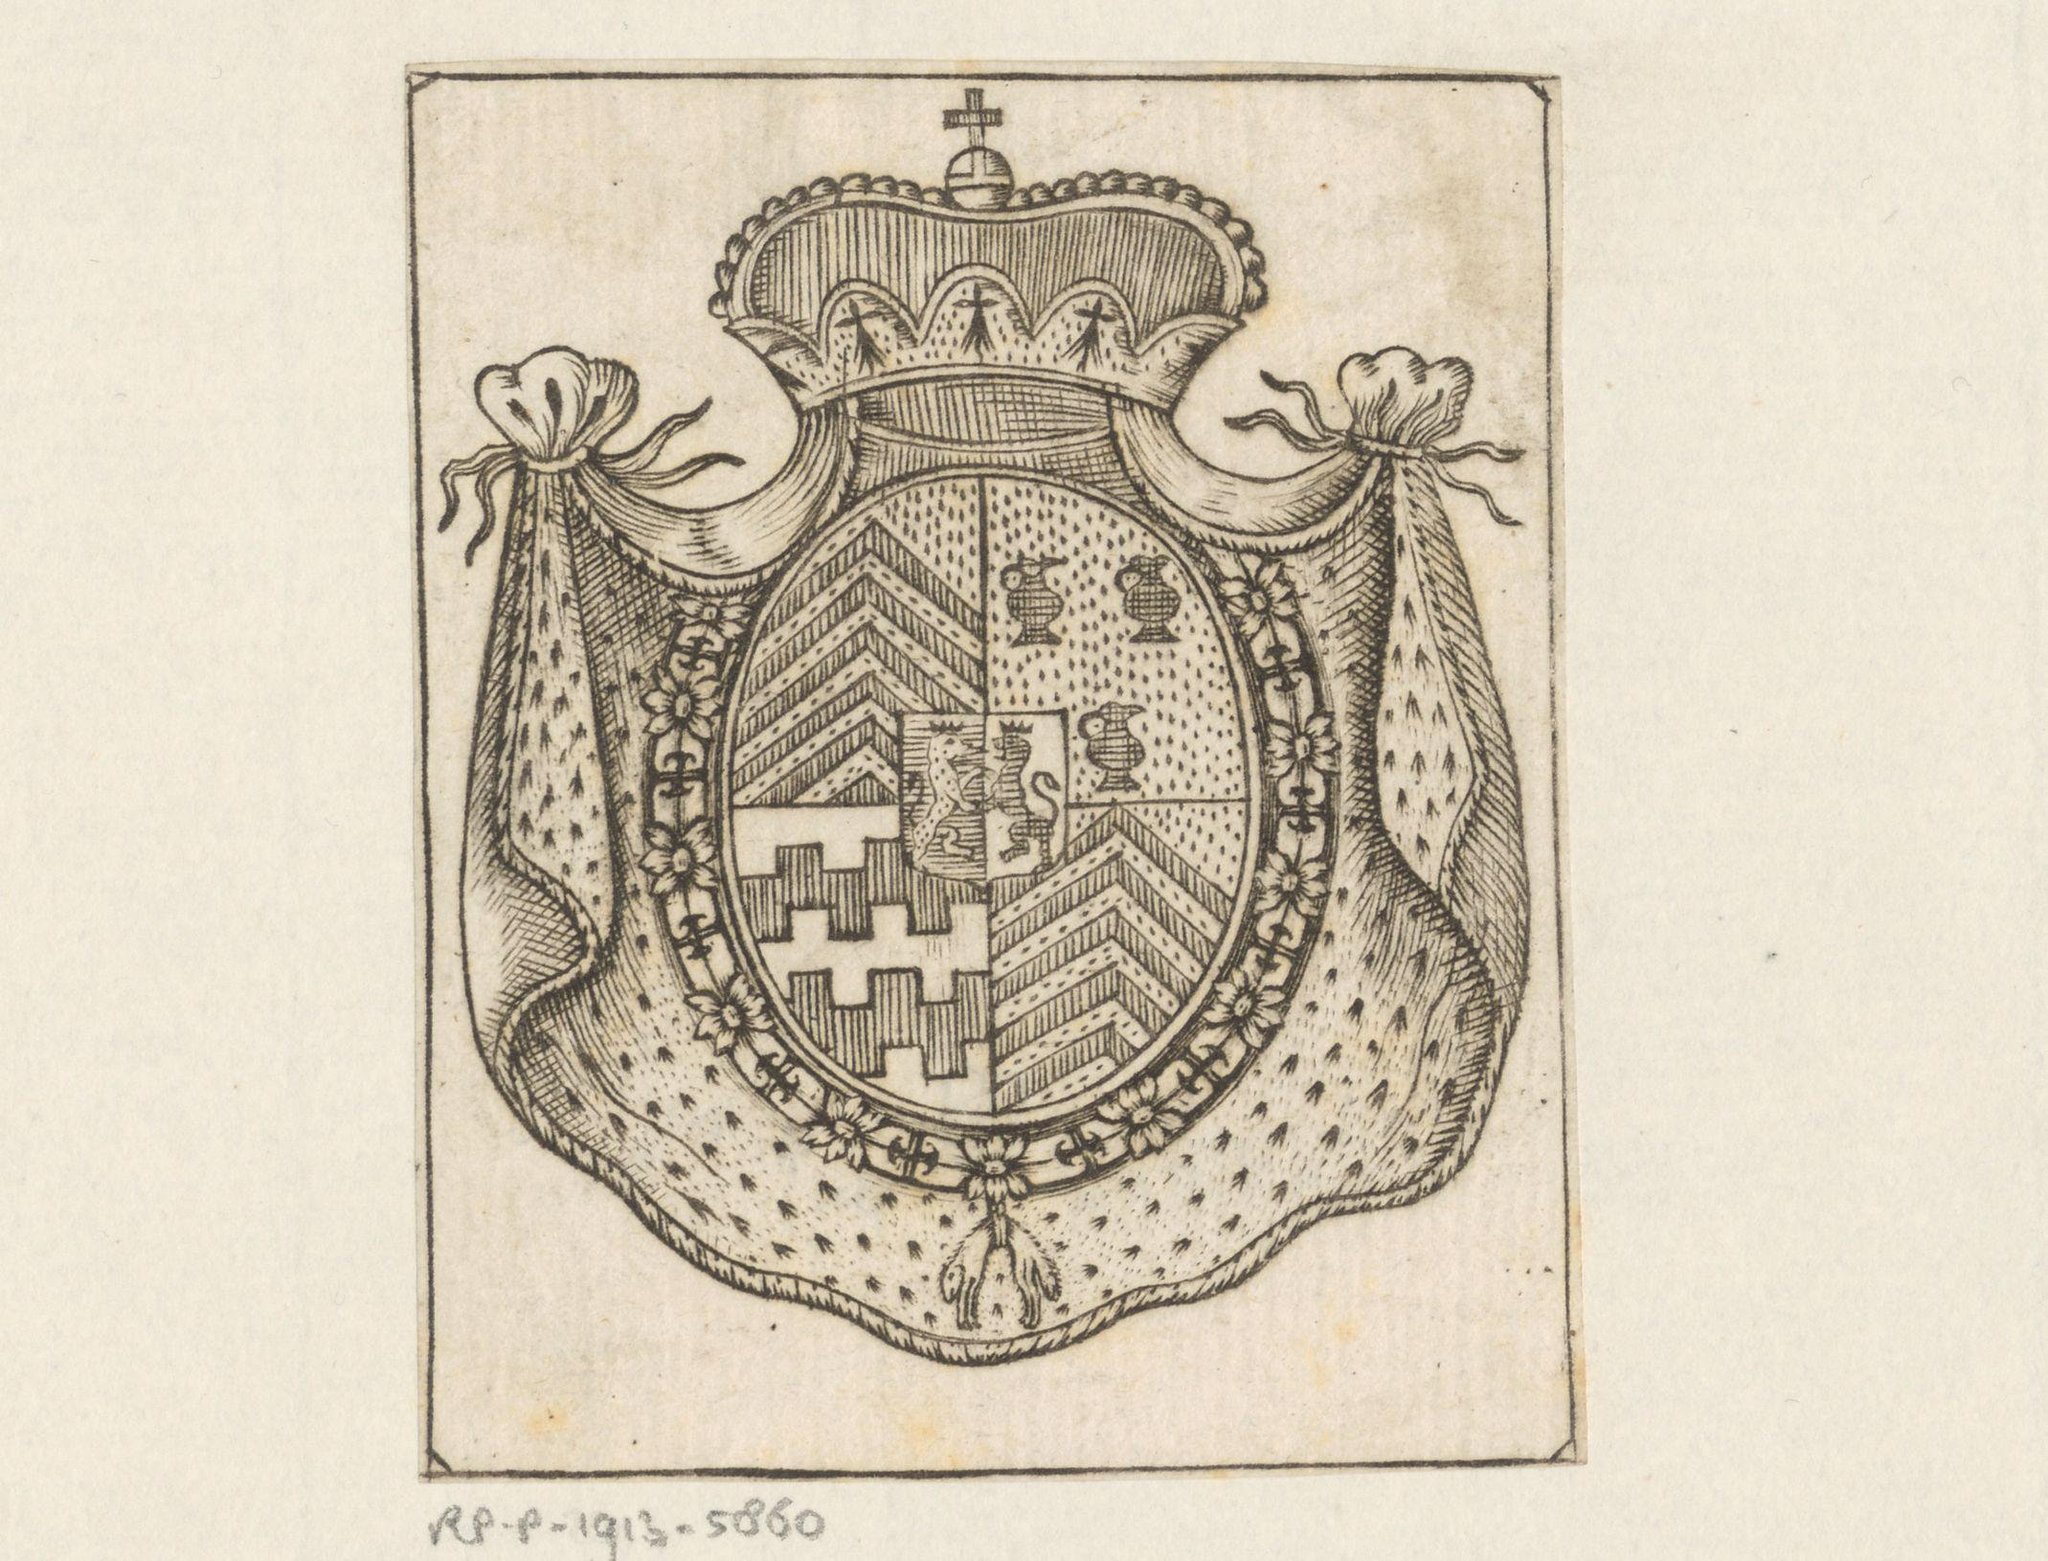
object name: bookplate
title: Ex libris van Casimir Pignatelli graaf van Egmont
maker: Anonymous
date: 1737-1801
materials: paper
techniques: etching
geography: italy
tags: armorial bearing, heraldry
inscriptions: collector's mark: Lugt 2233, collector's mark: Lugt 2760